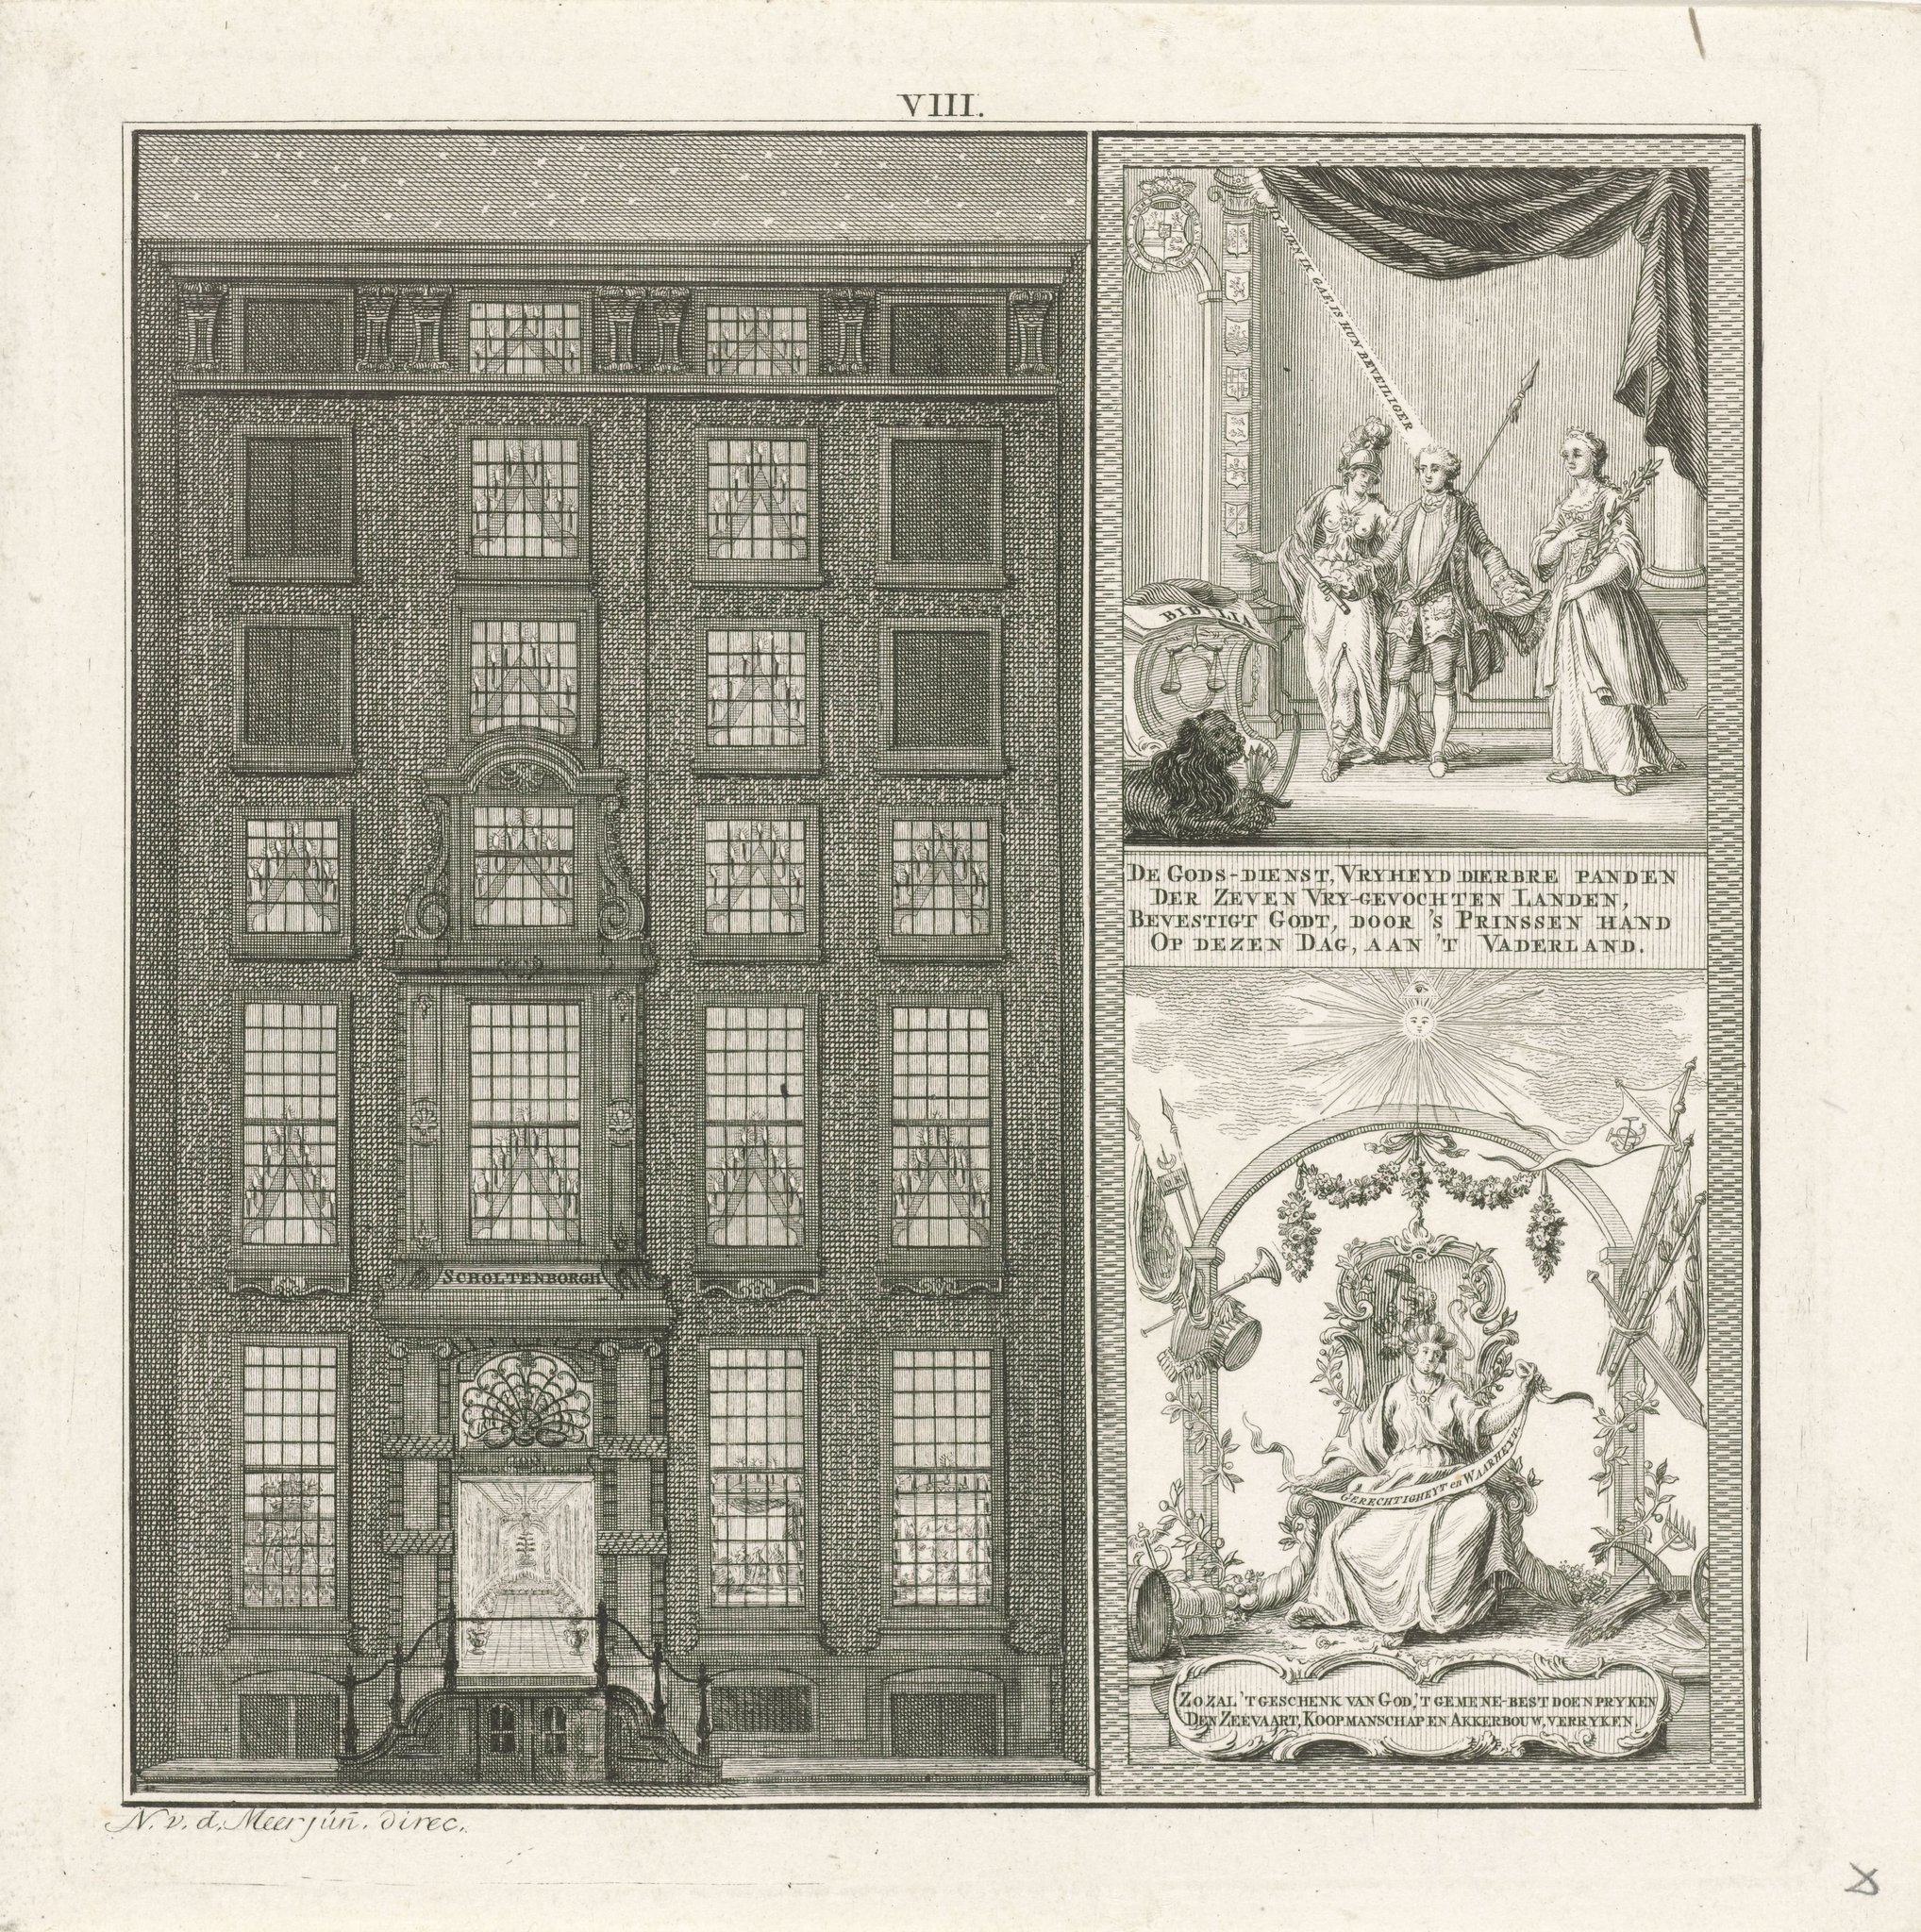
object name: book illustration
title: Illuminatië van het huis van de heer J.A. Scholten van Aschat te Amsterdam, 1766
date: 1776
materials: paper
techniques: etching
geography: amsterdam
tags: the hague, william v (prince of orange), faith, 'fides'; 'fede', 'fede catholica', 'fede christiana', 'fede christiana catholica' (ripa) ~ one of the three theological virtues, truth; 'verità' (ripa), public festivities, the all-seeing eye, triangle with eye ~ symbol of god the father, freedom, liberty; 'libertà' (ripa)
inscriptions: collector's mark: Lugt 2228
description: Verlichting van het woonhuis van de heer Scholten van Aschat in Amsterdam ter ere van de aantreding van Willem V als stadhouder in 1766. Rechtsboven stadhouder Willem V staande tussen Godsdienst en Vrijheid. De Hollandse leeuw ligt op de grond. Rechtsonder zit de personificatie van Gerechtigheid en Waarheid op de troon onder de zon van gerechtigheid en het alziend oog van God. De troon is gedecoreerd met de Hollandse leeuw met vrijheidslans. Bovenaan genummerd: VIII.